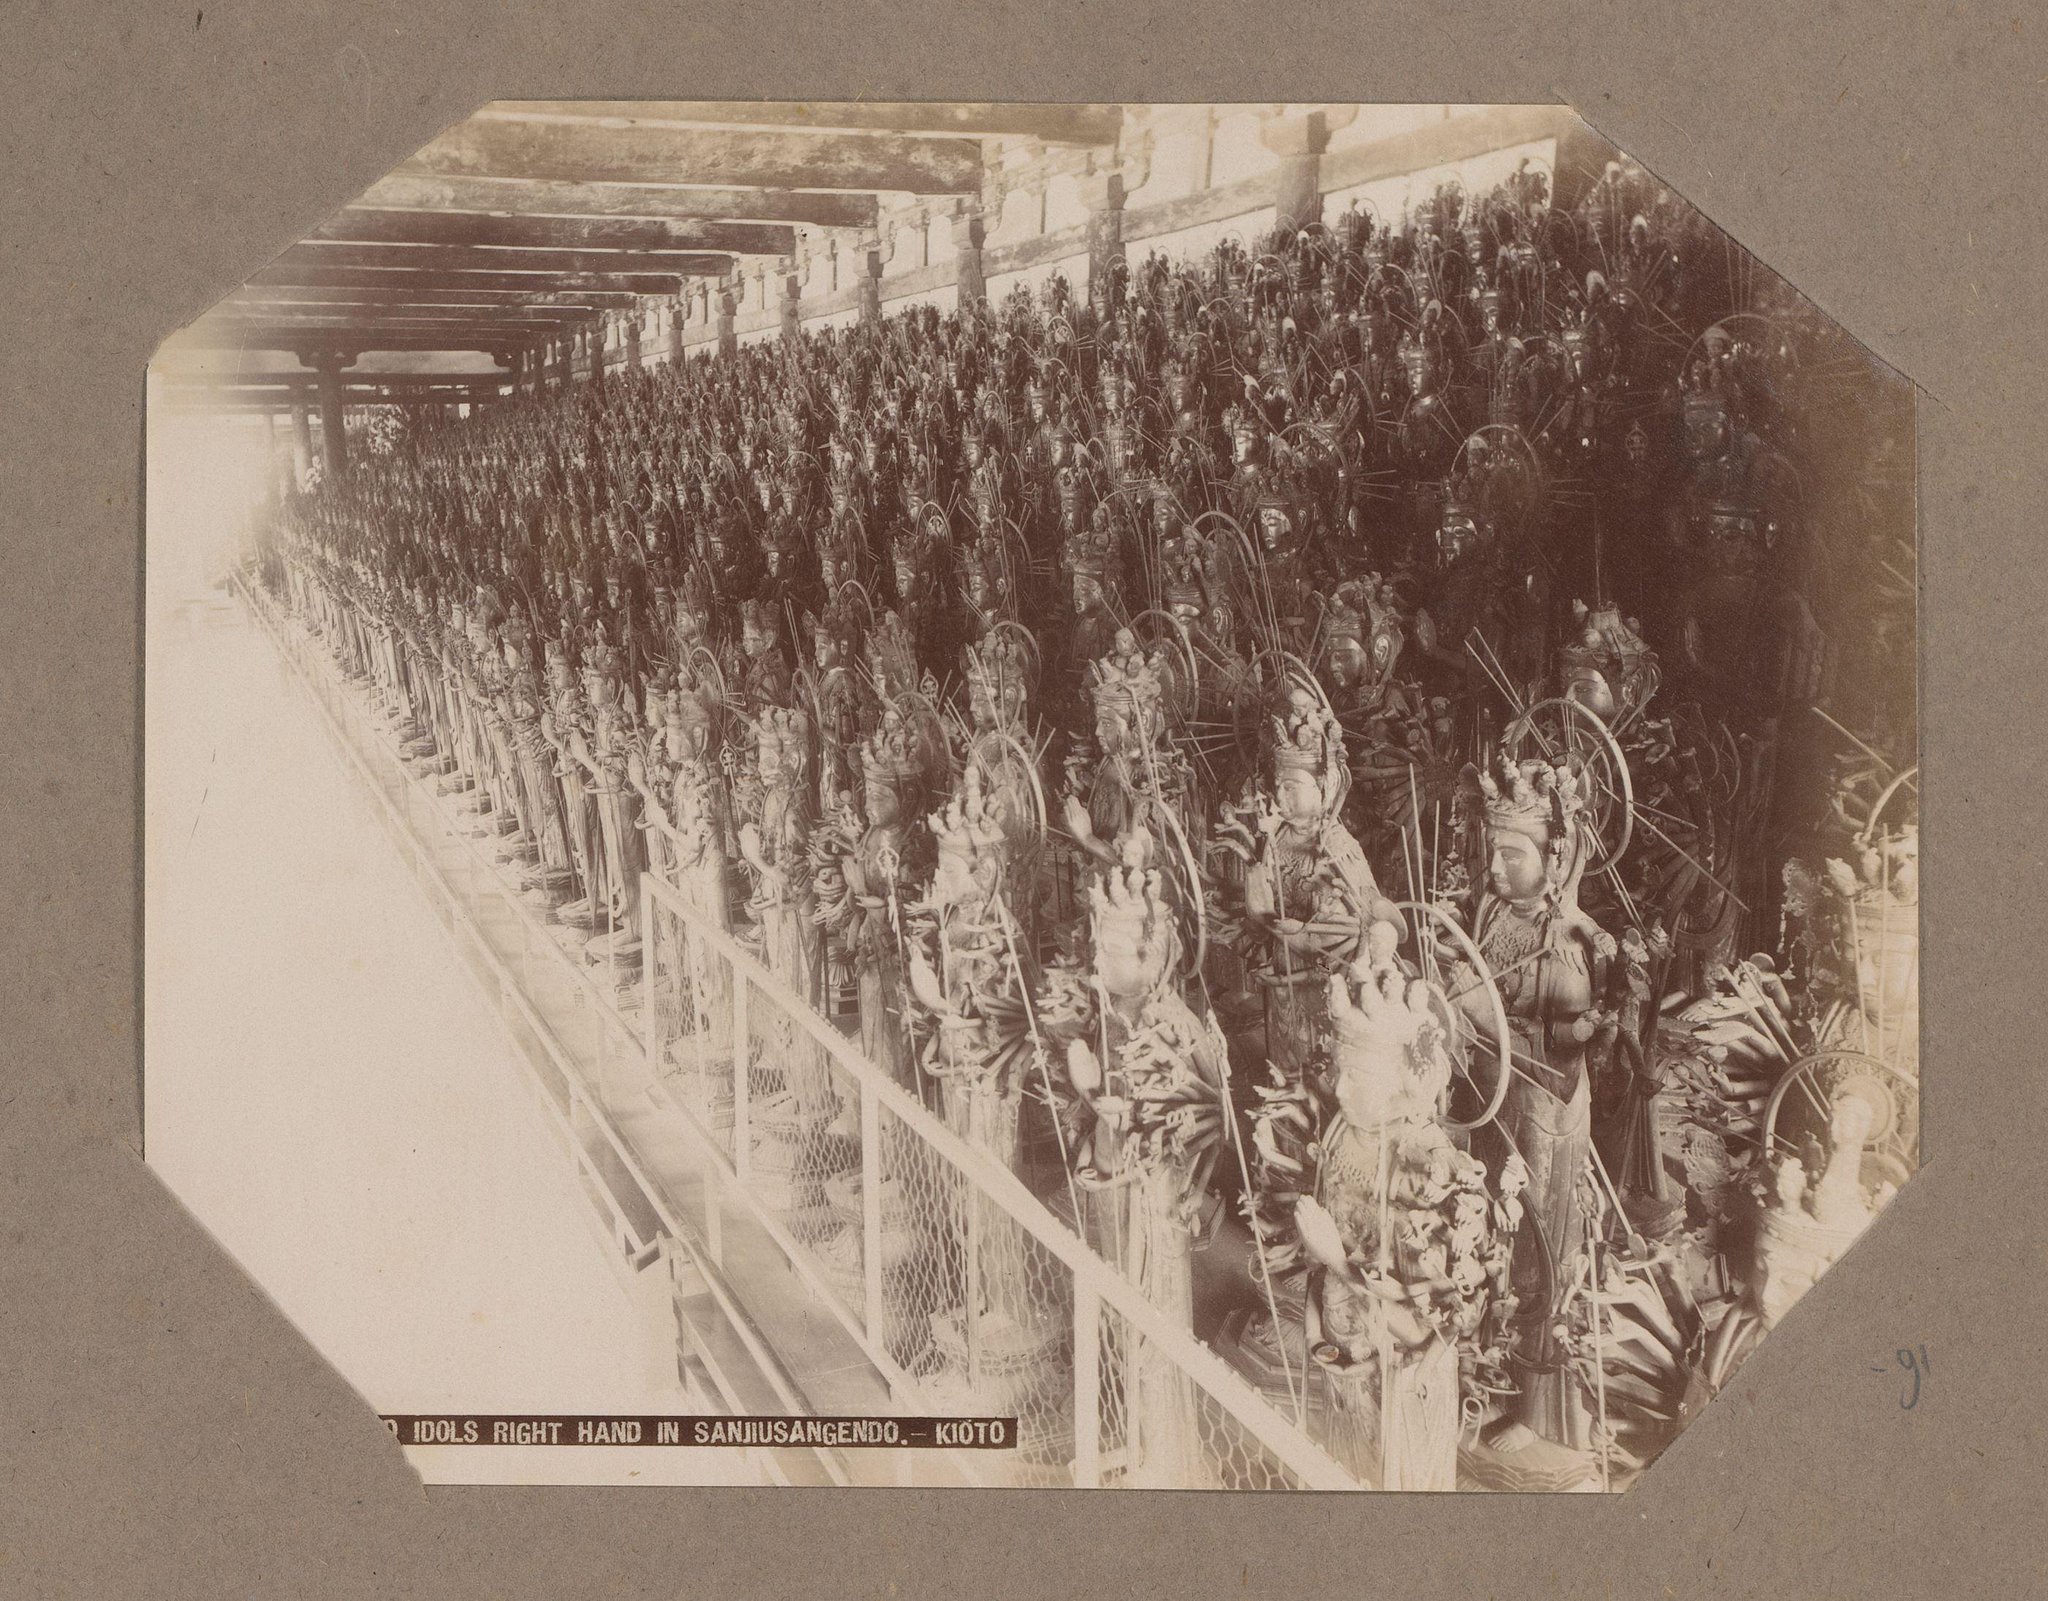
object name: photograph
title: Houten beelden van de godin Kannon in de Sanjusangen-do tempel in Kyoto, Japan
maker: Anonymous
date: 1890-1903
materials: paper, photographic support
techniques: albumen print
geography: kyoto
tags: temple, shrine ~ hinduism, buddhism, jainism, piece of sculpture, reproduction of a piece of sculpture, representations ~ goddesses, demi-goddesses, heroines, etc. (non-christian religions), kyoto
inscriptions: inscription: ‘24. Tnousand idols right hand in Sanjiusangendo, Kioto’